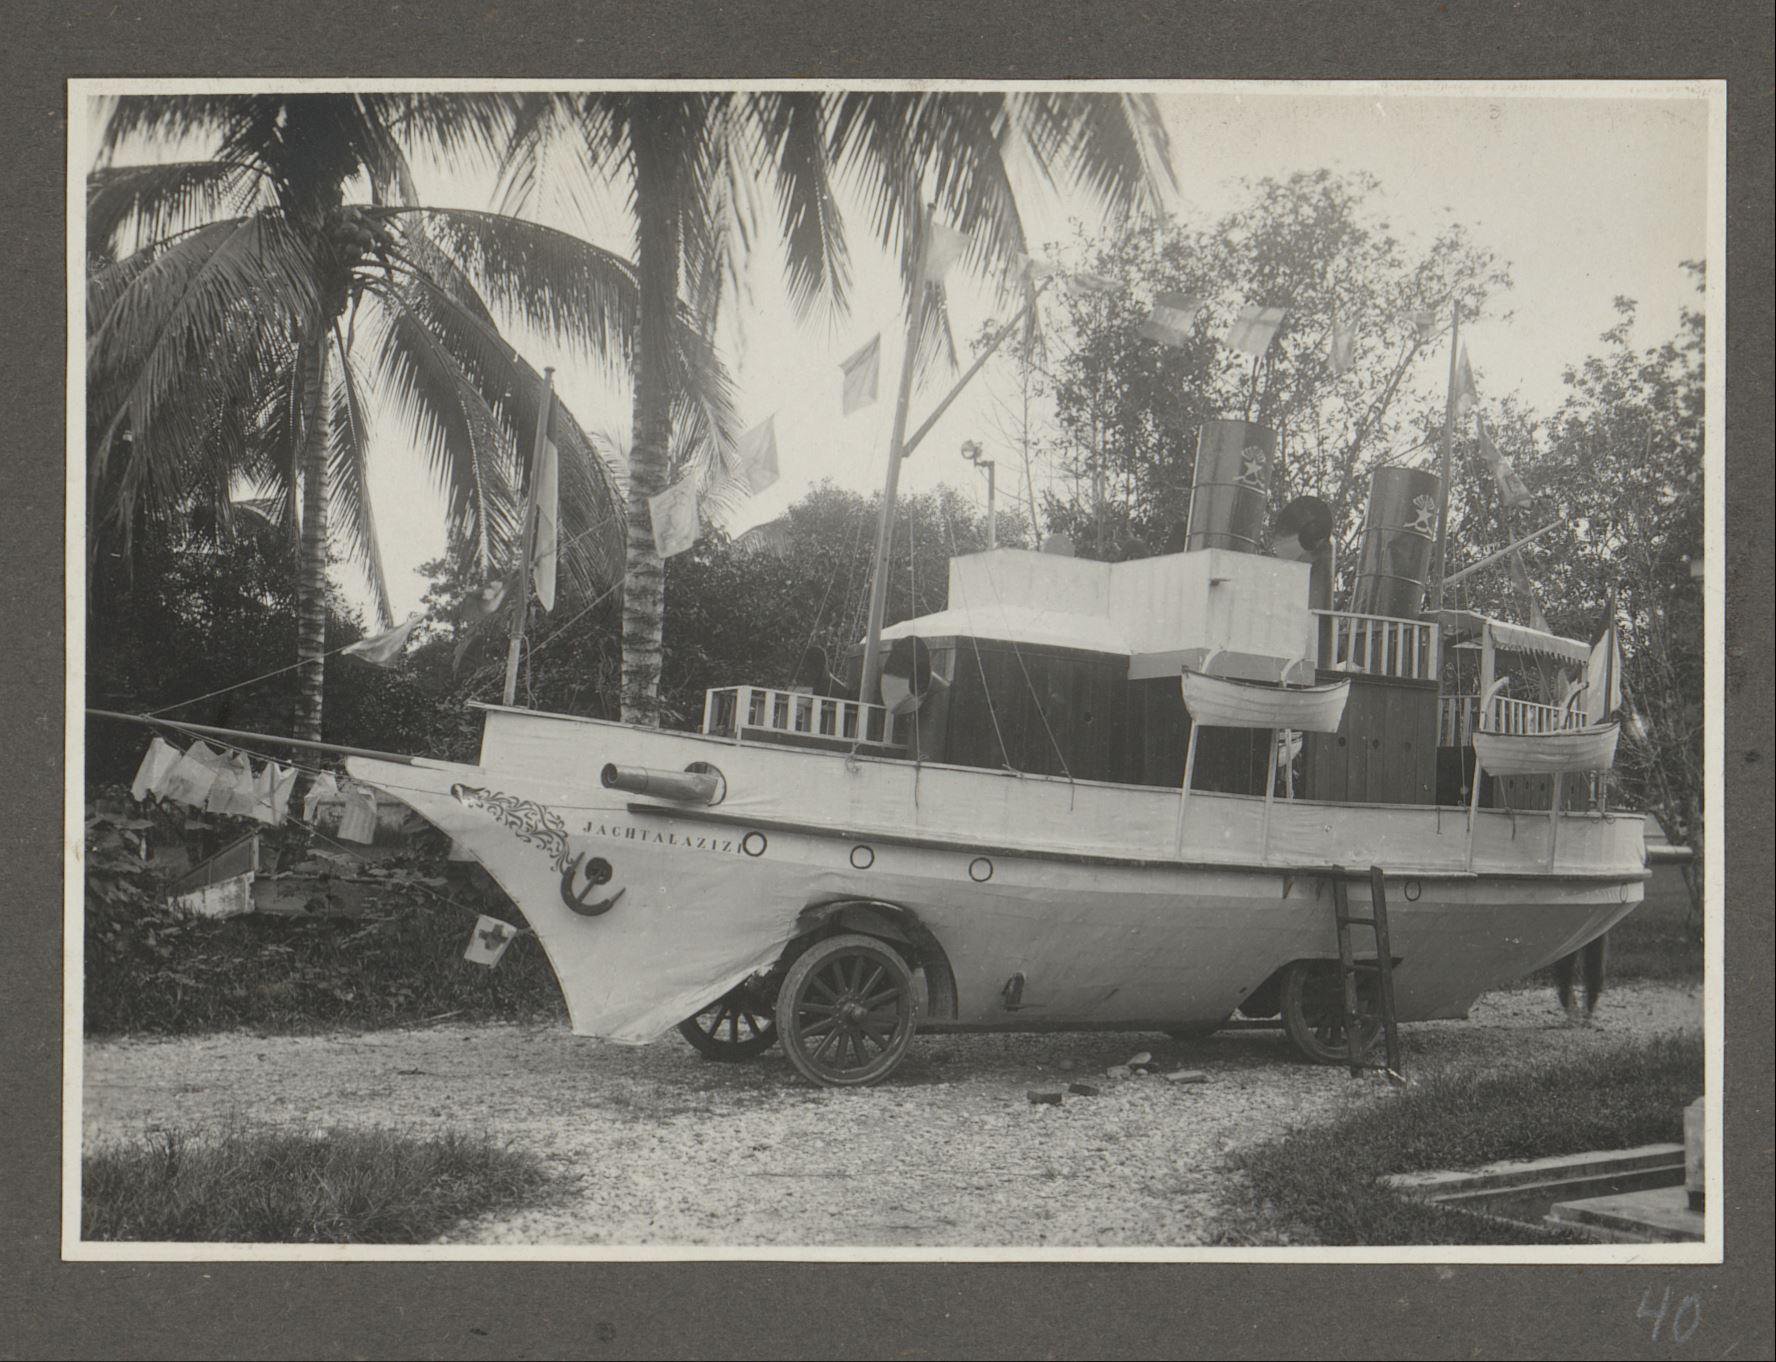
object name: photograph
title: Praalwagen met schip bij het paleis van de Sultan van Langkat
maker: Anonymous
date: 1919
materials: photographic support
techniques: gelatin silver print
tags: trees, float ~ triumph, sumatra